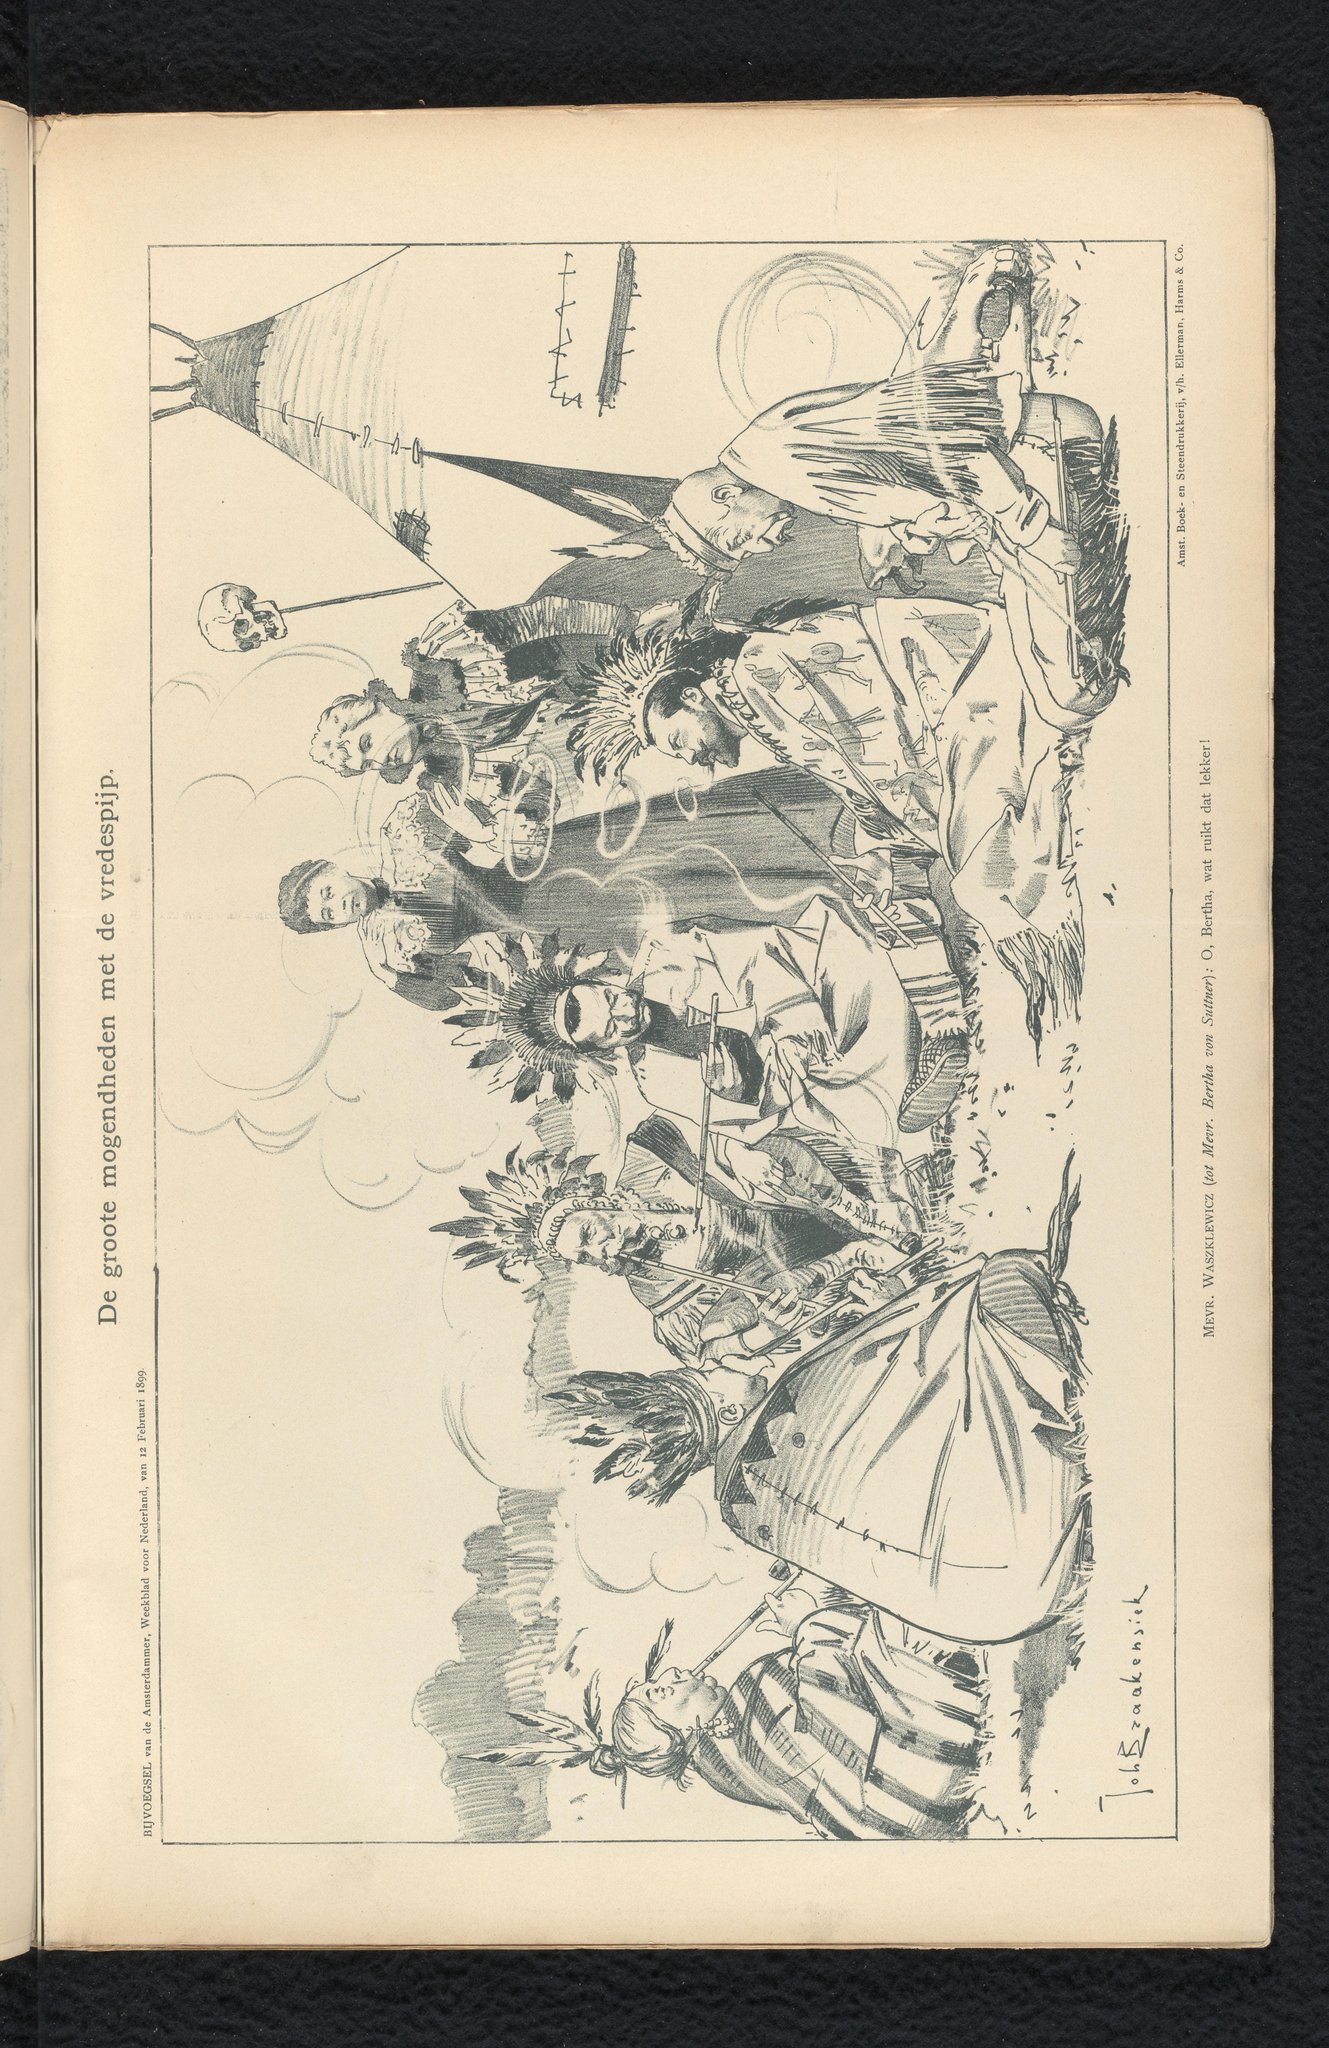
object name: cartoon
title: De groote mogendheden met de vredespijp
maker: johan braakensiek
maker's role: draughtsman, print maker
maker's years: 1858-1940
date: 1899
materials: paper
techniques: lithograph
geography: amsterdam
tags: vienna, wilhelm ii (keizer van duitsland), symbols, allegories of peace, 'pax'; 'pace' (ripa), tepee, tipi, teepee, pipe ~ tobacco, indigenous peoples of north america, political caricatures and satires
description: Leiders van Europese landen verkleed als stereotiepe oorspronkelijke bewoners van Noord-Amerika, roken de vredespijp zittend op de grond voor een tipi. Twee vrouwen van de internationale vredesbeweging kijken goedkeurend toe.